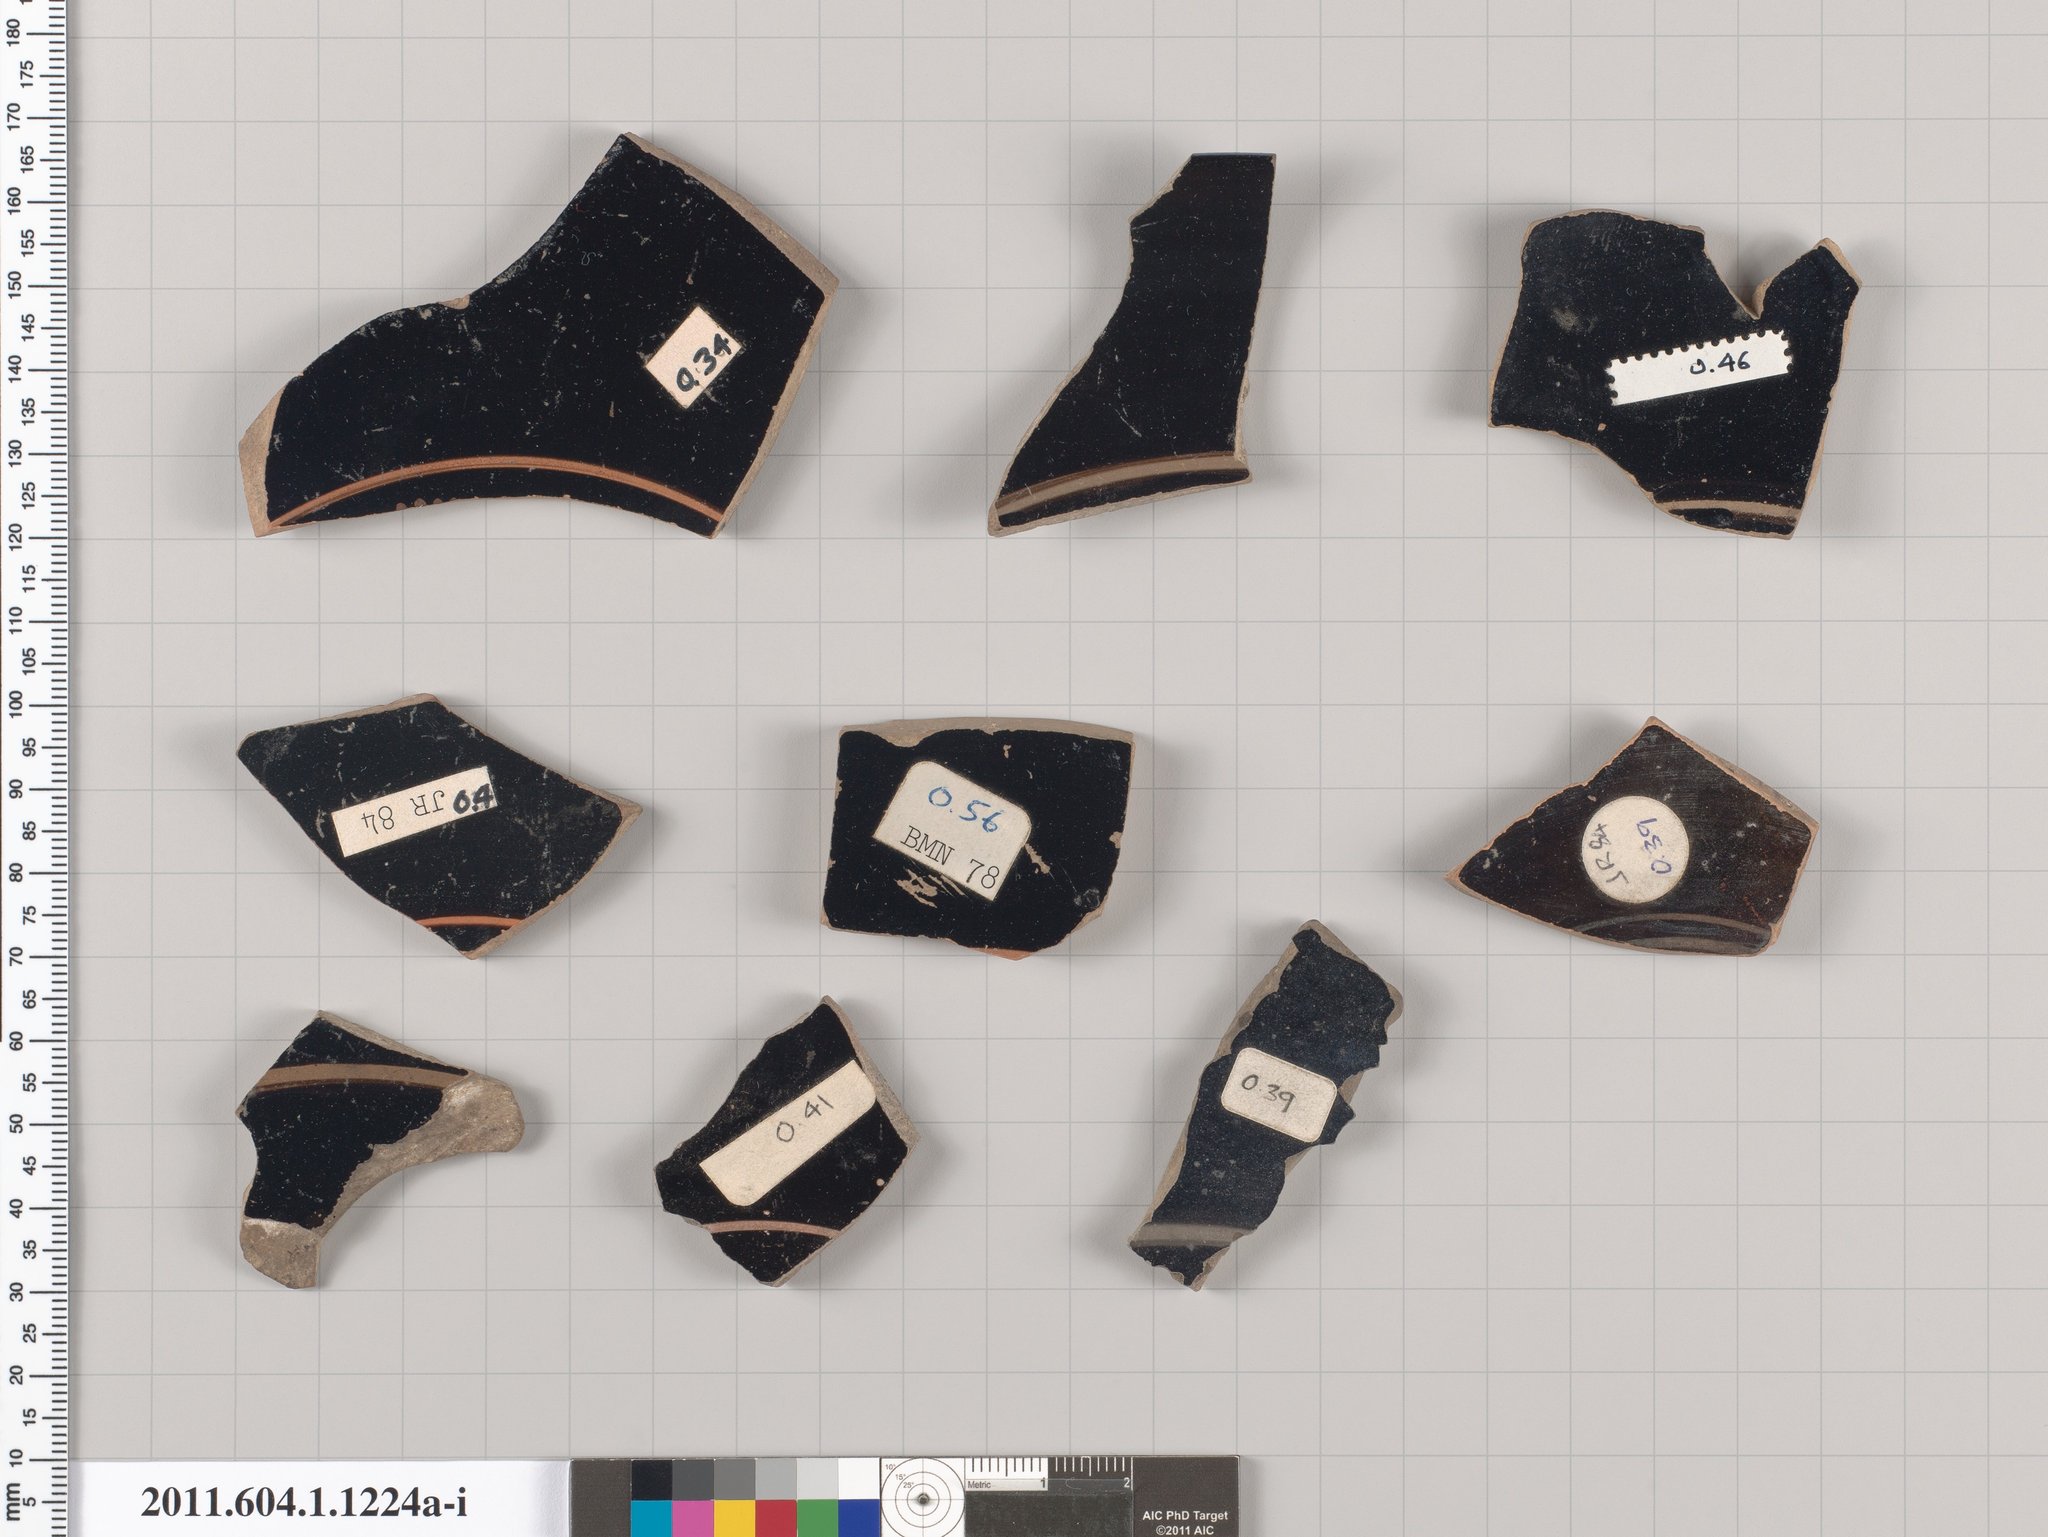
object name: kylix fragment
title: Terracotta fragments of kylikes (drinking cups)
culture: greek, attic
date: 600-401 BCE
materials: terracotta